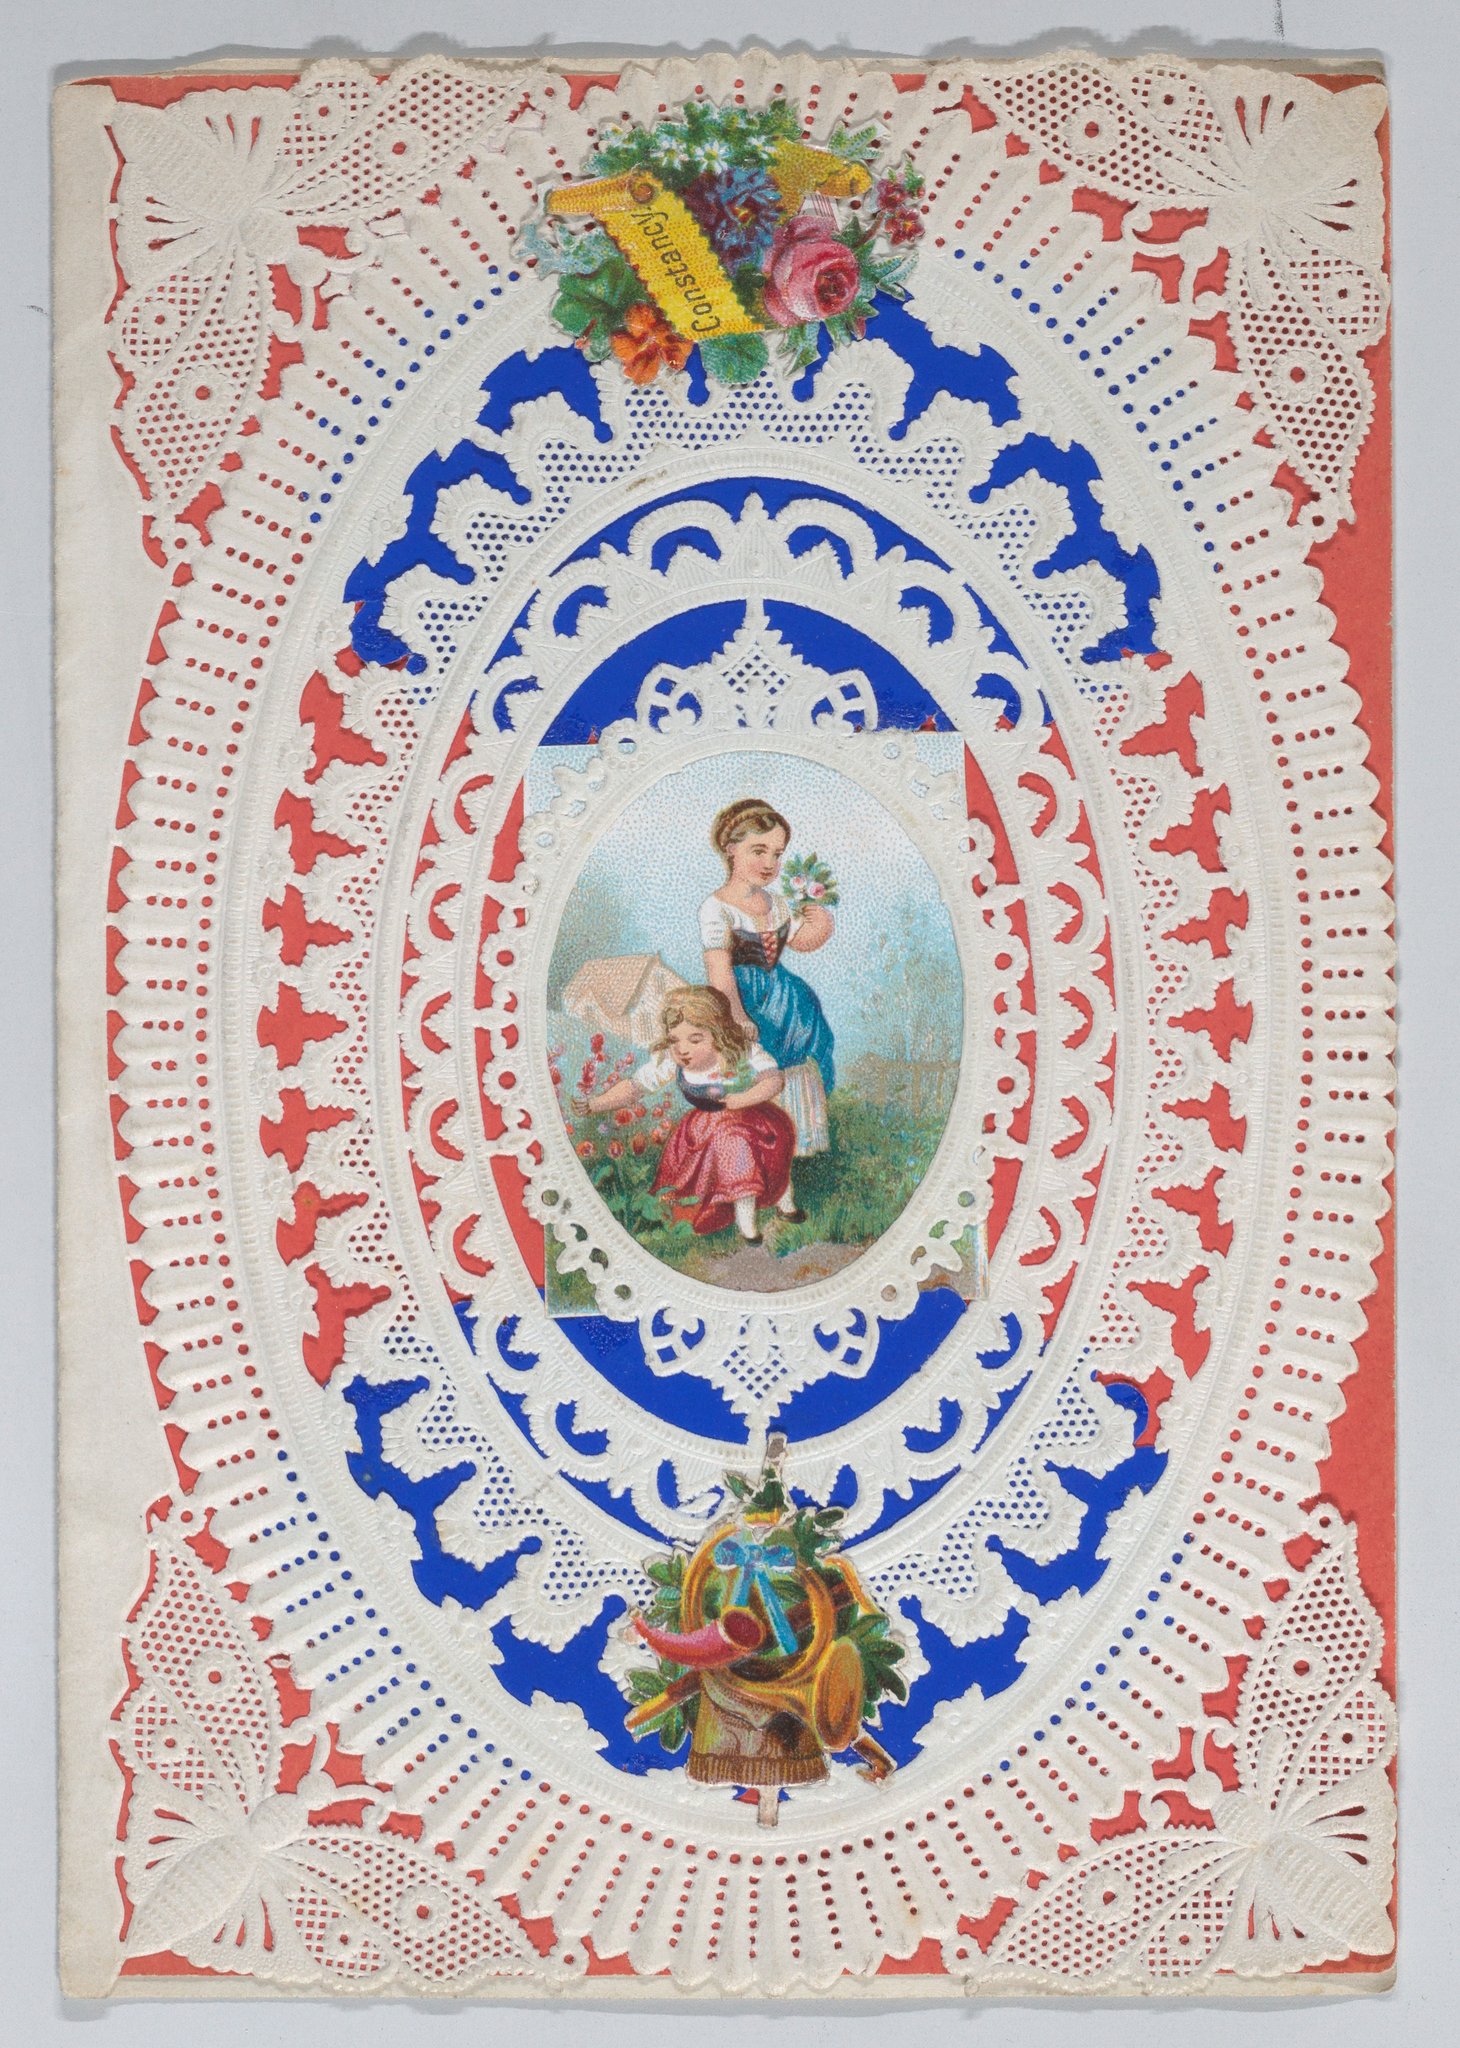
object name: valentine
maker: esther howland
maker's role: artist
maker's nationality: american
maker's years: 1828-1904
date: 1850-1860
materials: paper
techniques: cutting, embossing, open work